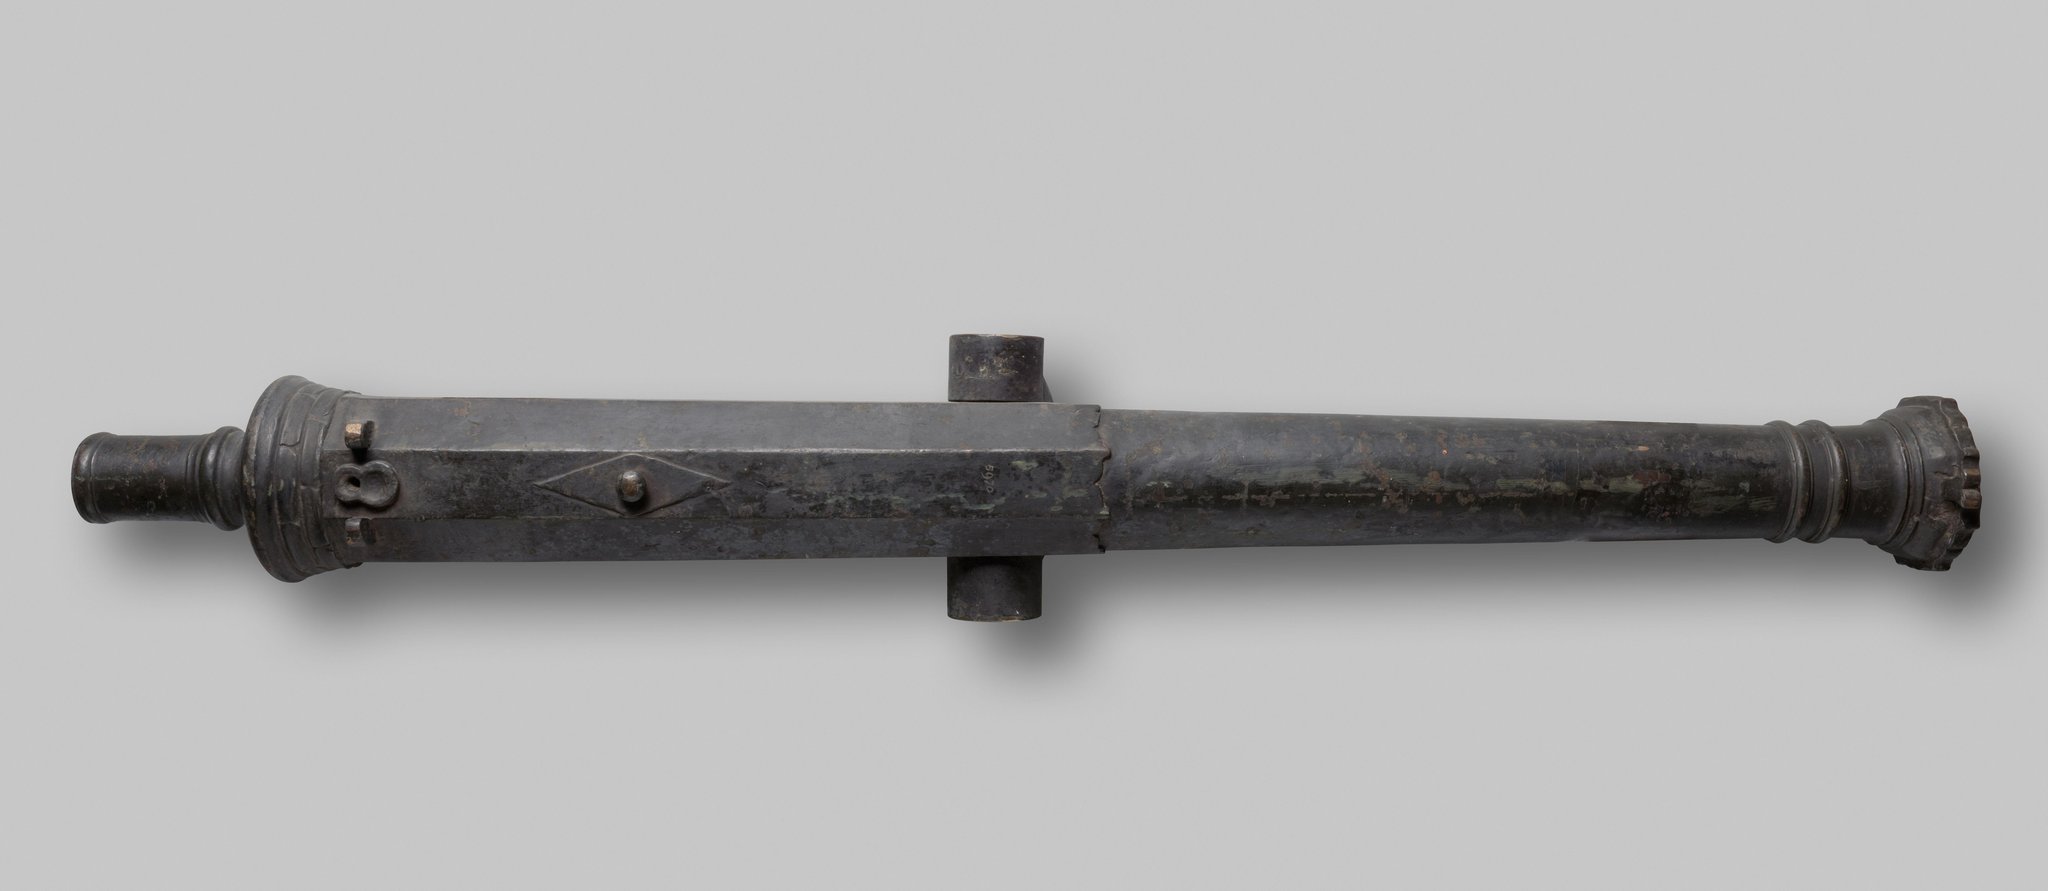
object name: lilla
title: Lantaka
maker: Anonymous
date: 1750-1850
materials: bronze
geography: indonesian archipelago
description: Bronzen voorlader op mik. De loop heeft een wijde monding, het middenstuk is rond en het achterste gedeelte achtkantig. De staart is hol voor een houten richtstok. Aan weerszijden van het zundgat een vierkante knop voor een zundgatdeksel. Vóór het zundgat een ruitvormig ornament met daarop een richtknop, en bij de monding een verhoogde korrel met spleet. De ogen van de mik zijn geheel om de de tappen heen gesmeed, zodat het stuk niet uit de mik getild kan worden. De ziel van het stuk is vrij grof, zodat het om een kern gegoten en niet uitgeboord schijnt te zijn. Voor kogel van 1,5 pond.